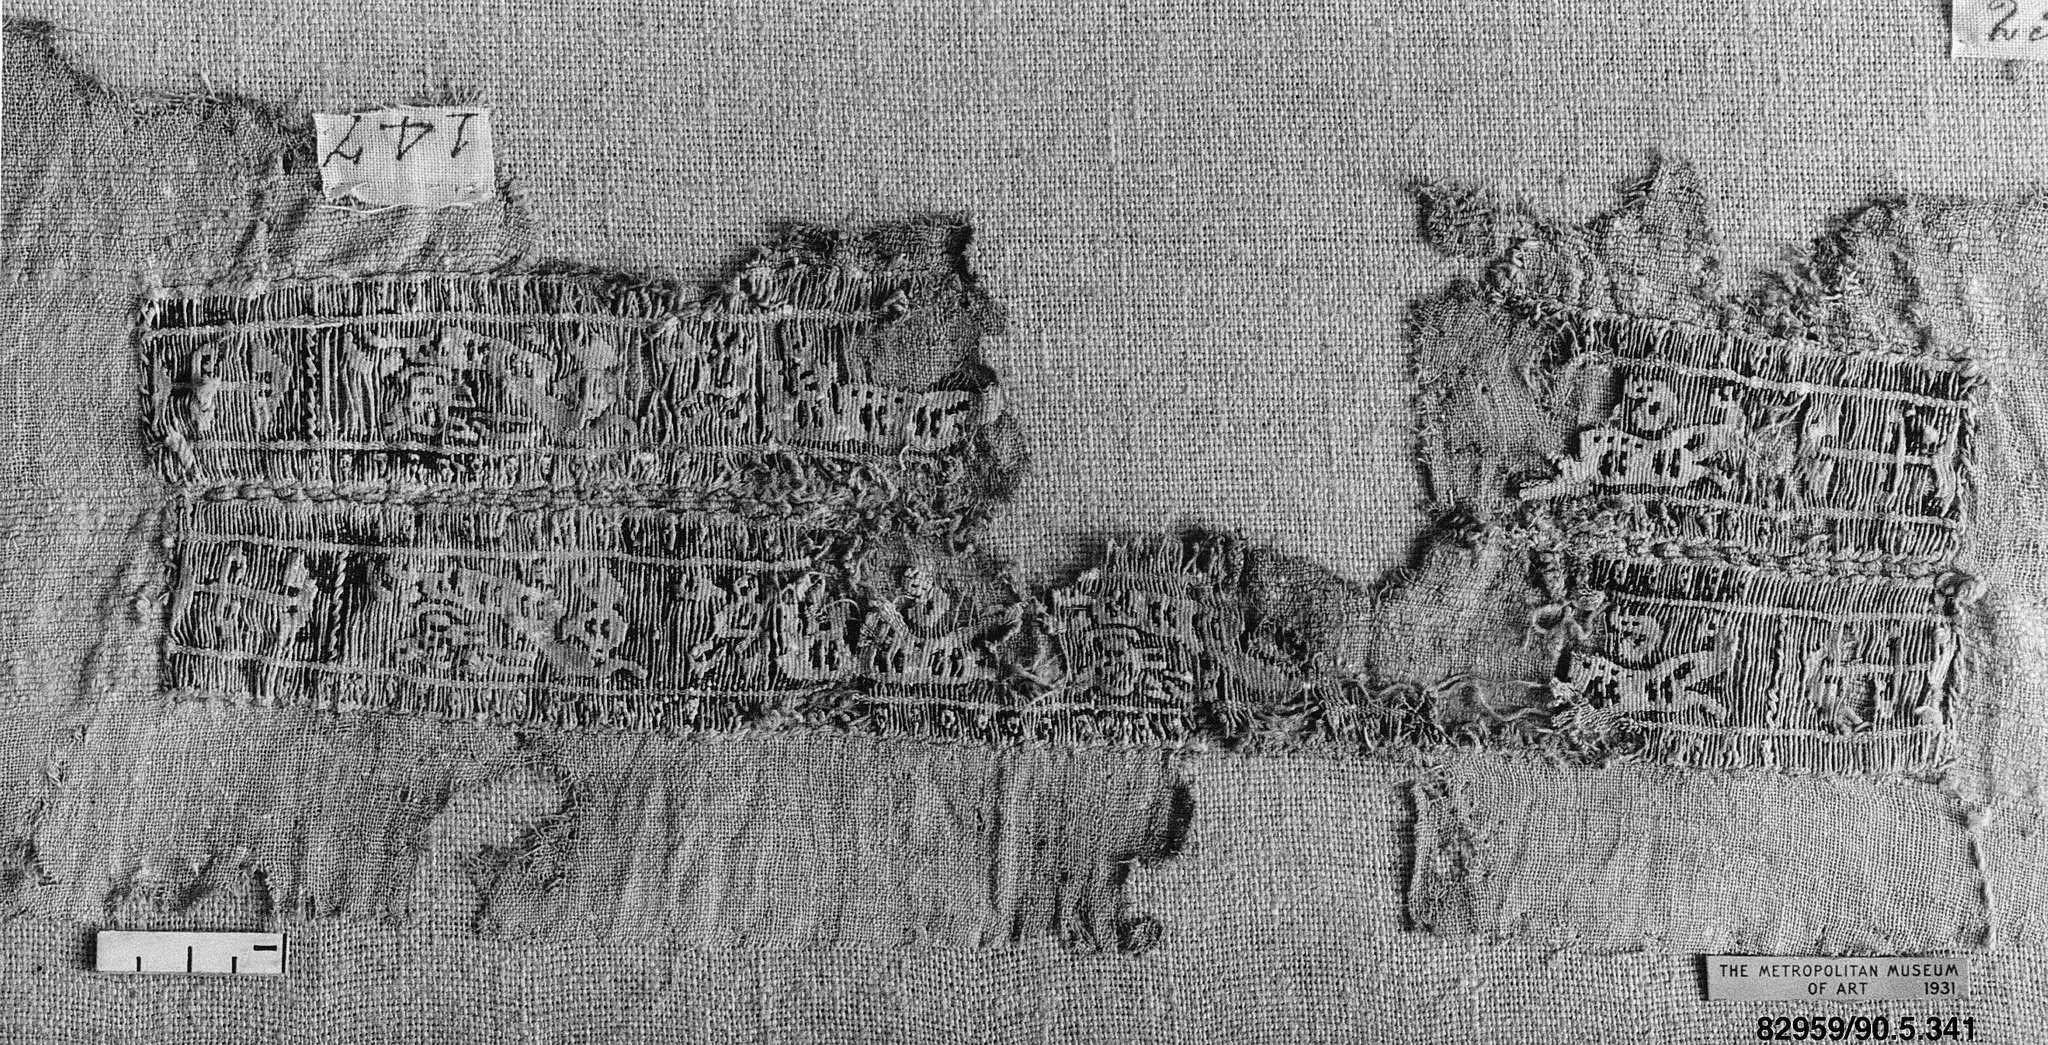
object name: textile fragment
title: Fragment of a Tunic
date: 201-400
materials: linen, wool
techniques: weave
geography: egypt